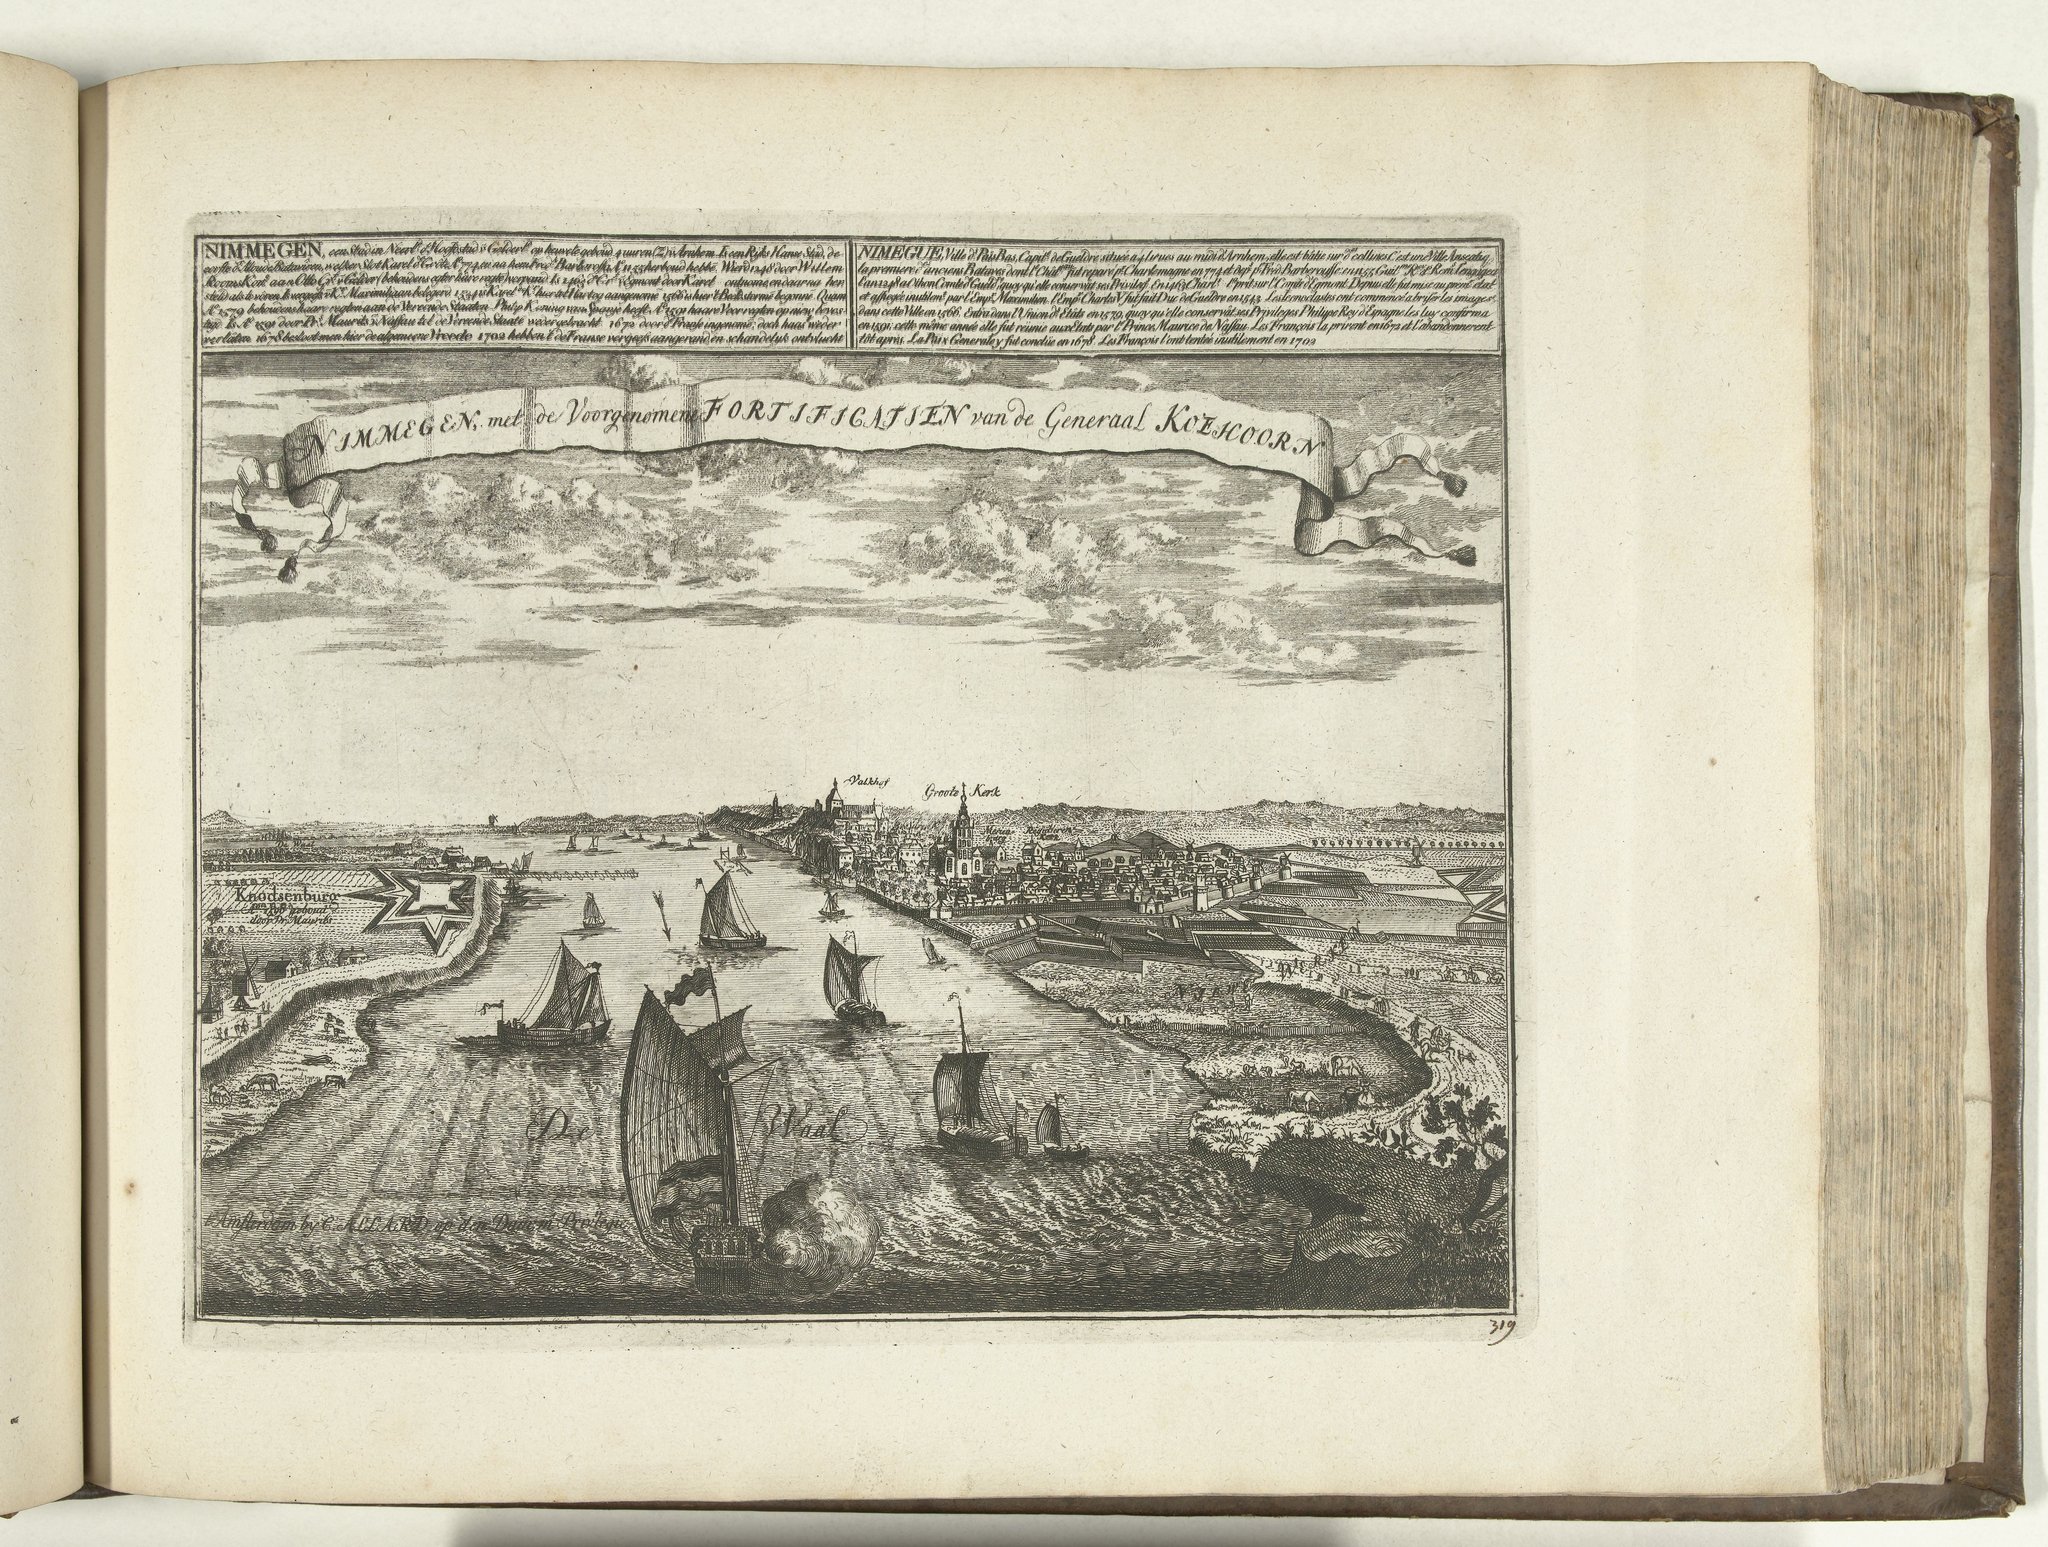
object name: print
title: Gezicht op Nijmegen met de geplande fortificaties ontworpen door Menno van Coehoorn, 1726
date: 1726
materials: paper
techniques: etching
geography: northern netherlands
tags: the hague, nijmegen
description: Gezicht op Nijmegen aan de Waal met de geplande nieuwe fortificaties ontworpen door Menno baron van Coehoorn. Plaat nr. 319 in deel XIII van het prentwerk: Les Forces de l'Europe, Asie, Afrique et Amerique ... Comme aussi les Cartes des Côtes de France et d'Espagne uit 1726, dit tweede deel met 271 met de hand genummerde platen van vermaarde sterke steden en vestingen in het kader van de Spaanse Successieoorlog 1701-1713. Voor het merendeel zijn deze platen gekopieerd naar de anonieme Franse platen van vermaarde sterke steden en vestingen: in Les forces de l'Europe en in: Le theatre de la guerre, dans les Pays-Bas, beide oorspronkelijk uitgegeven door Nicolas de Fer te Parijs (1693-1697) in het kader van de Negenjarige Oorlog. Titels in het Frans en Nederlands.